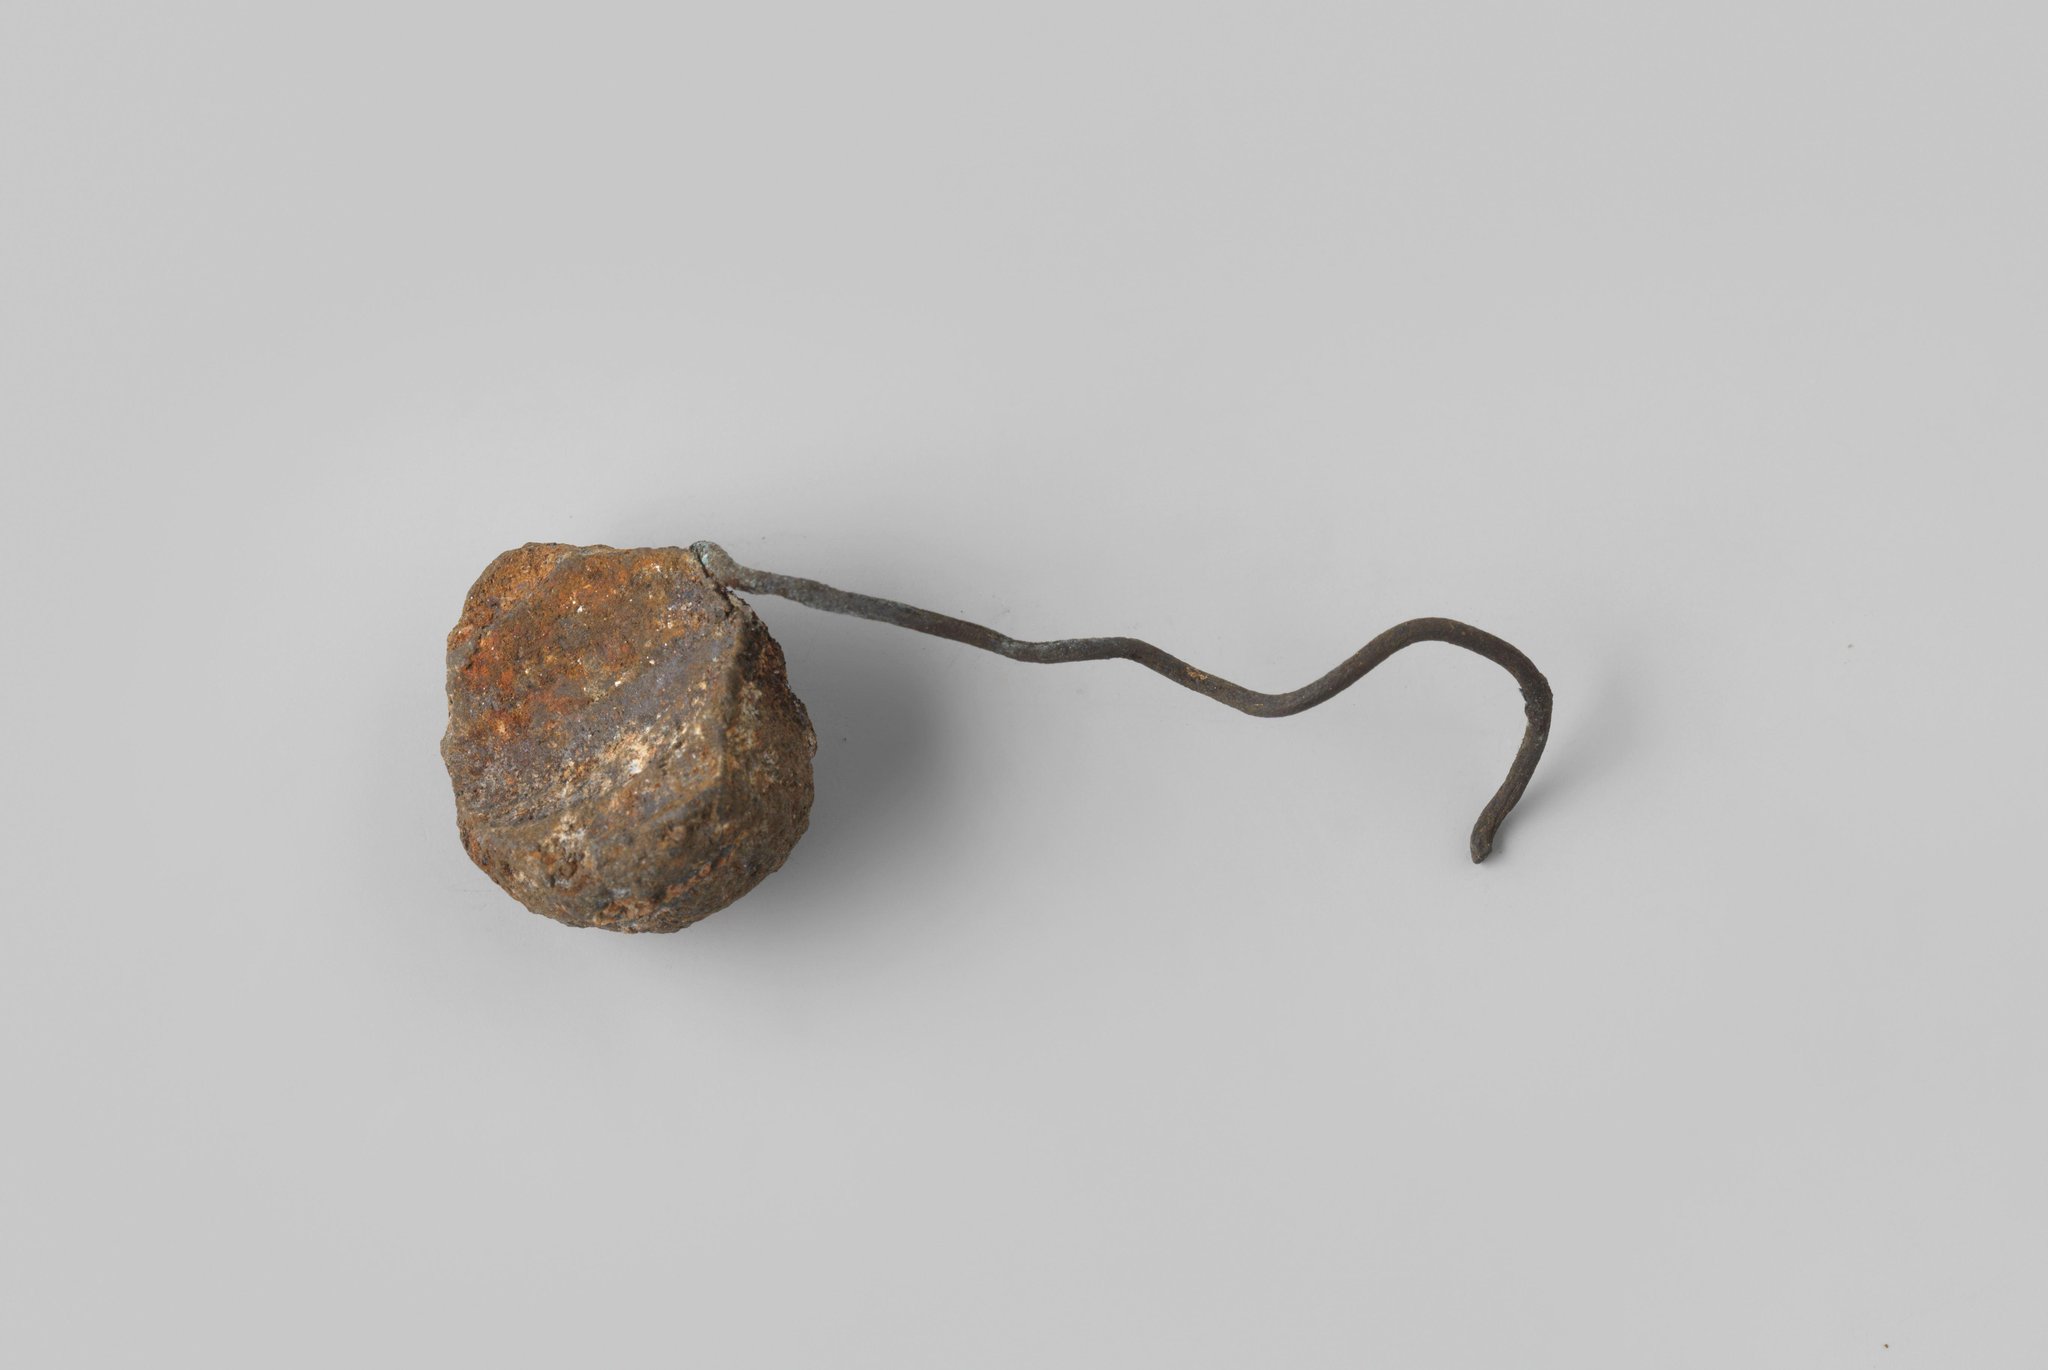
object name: chain shot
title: Kettingkogel uit het wrak van de Oost-Indiëvaarder Hollandia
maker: Anonymous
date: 1700-1743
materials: lead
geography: netherlands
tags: verenigde oostindische compagnie, hollandia (schip), annet